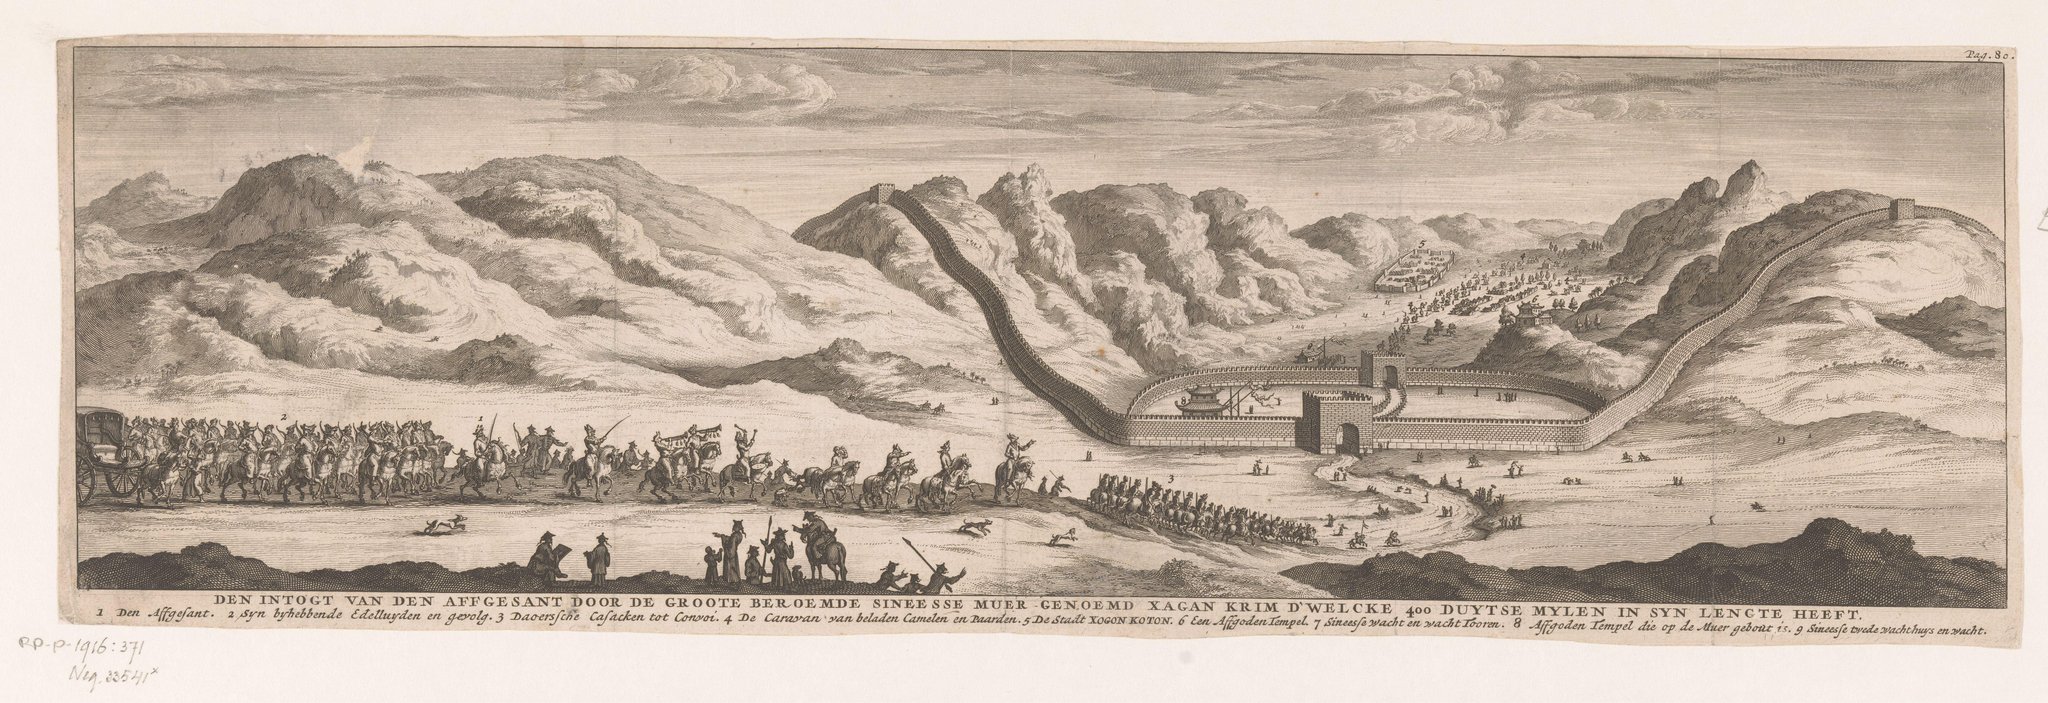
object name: print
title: Den intogt van den affgesant door de groote beroemde sineesse muer genoemd Xagan Krim d'welcke 400 duytse mylen in syn lengte heeft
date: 1710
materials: paper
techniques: engraving, etching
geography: amsterdam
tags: ambassador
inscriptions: collector's mark: Lugt 2228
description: Een lange stoet rond de Russische diplomaat Eberhard Isbrand Ides trekt door een poort in de Chinese Muur, bij Xogon Koton. Onder de prent de titel en een legenda.